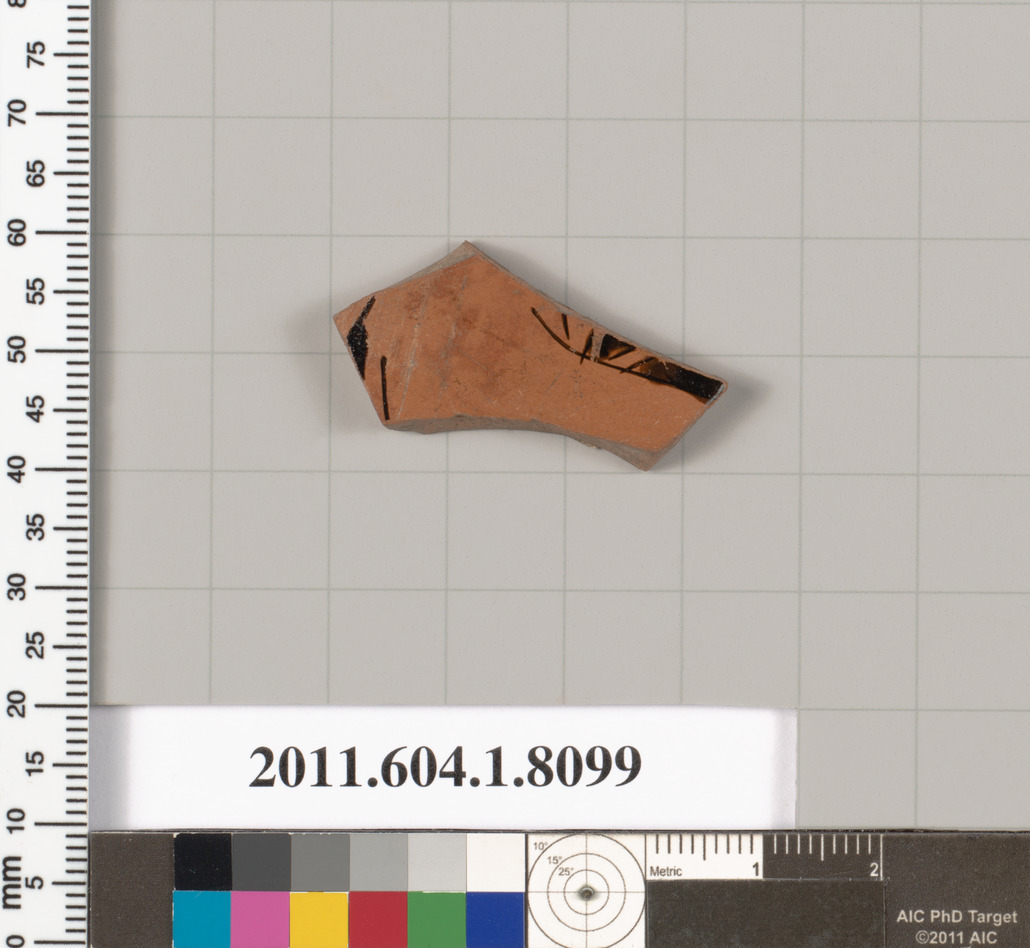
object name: kylix fragment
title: Terracotta fragment of a kylix (drinking cup)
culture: greek, attic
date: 520-510 BCE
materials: terracotta